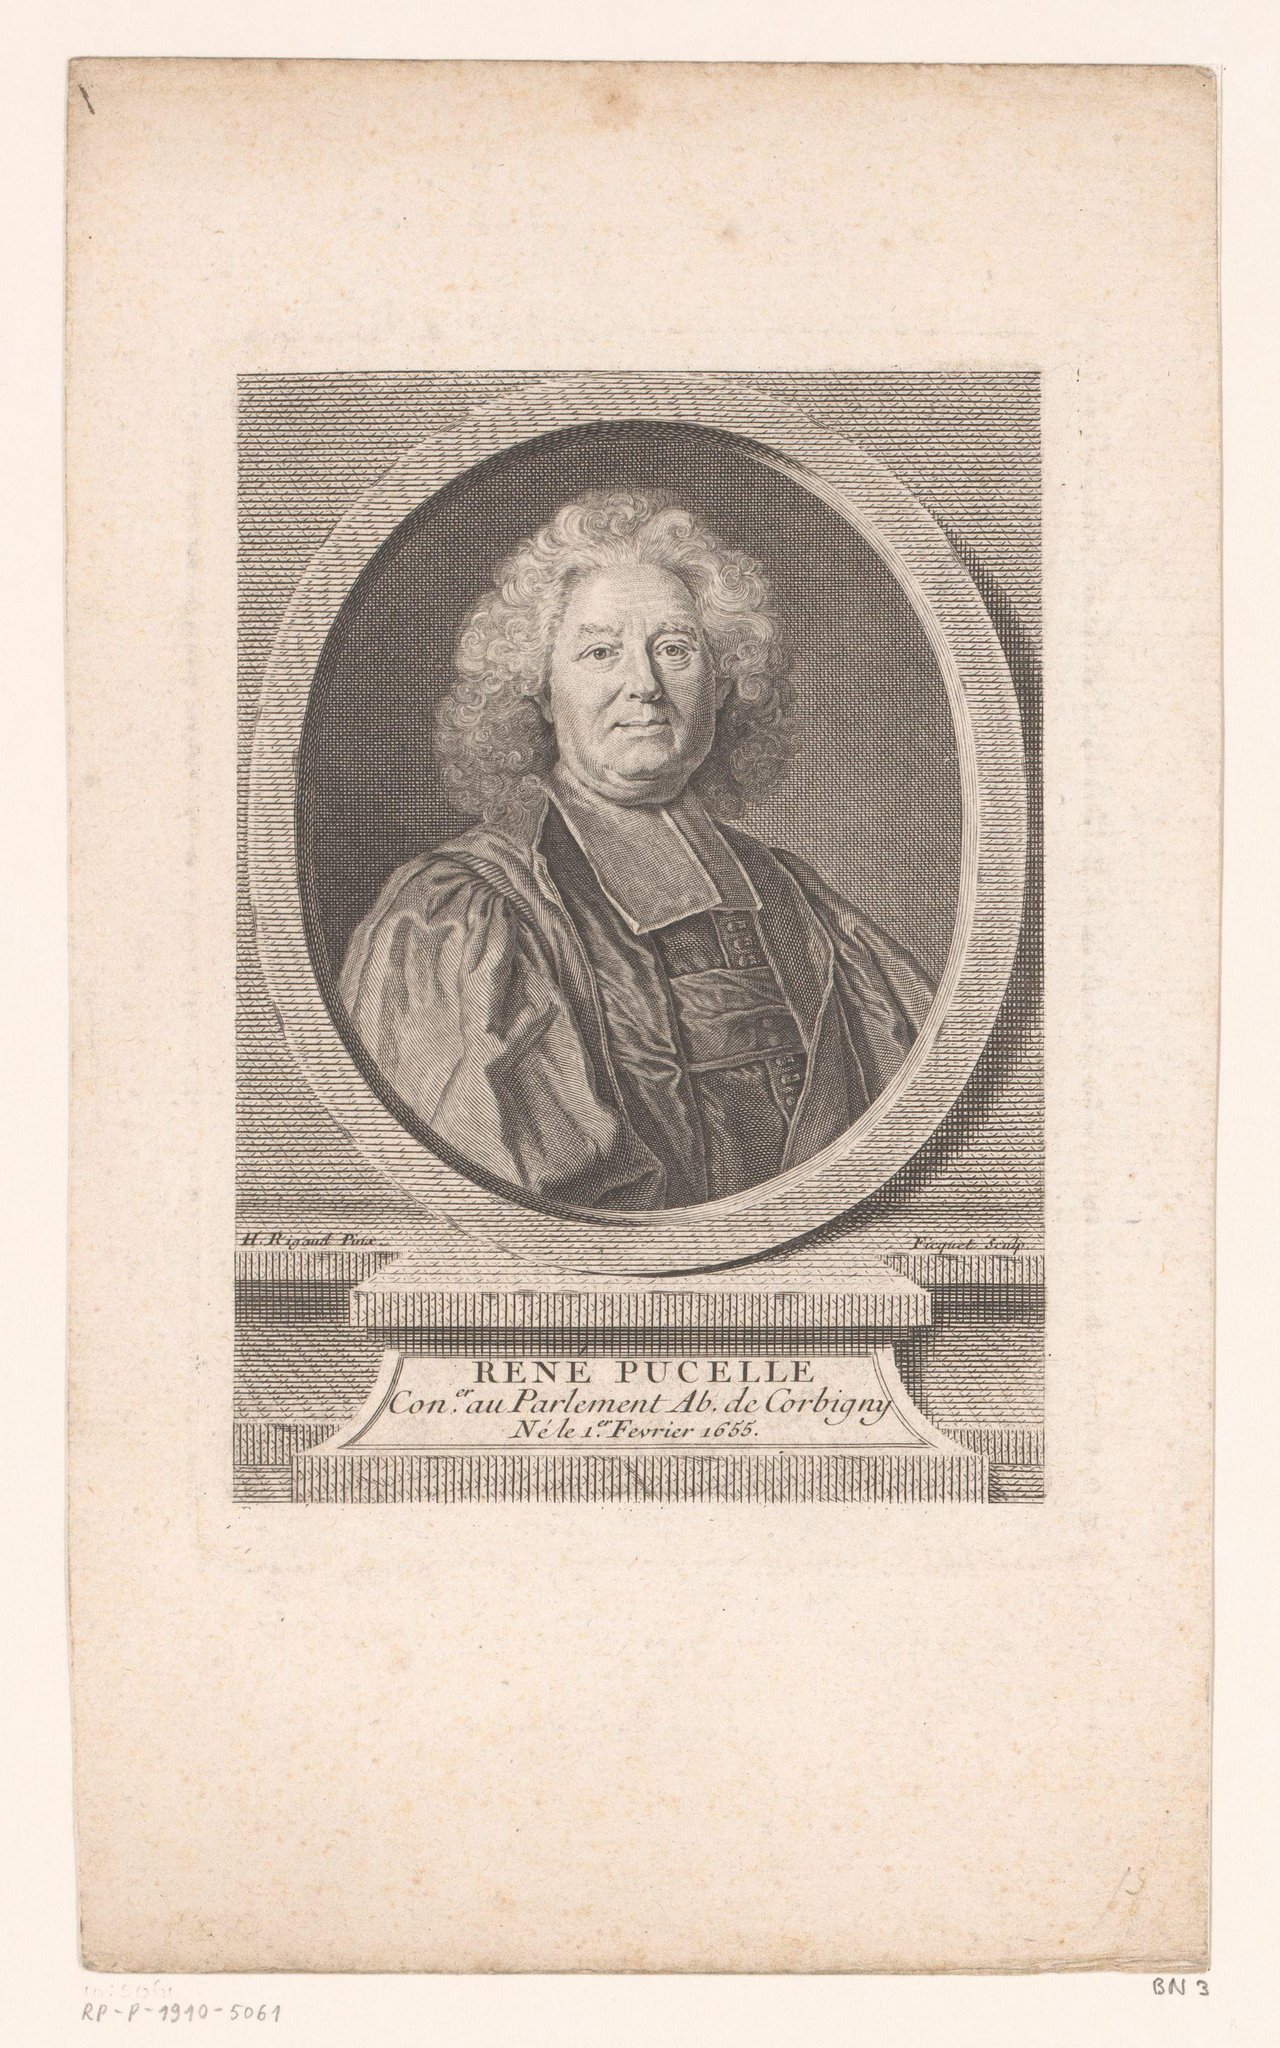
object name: print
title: Portret van René Pucelle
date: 1741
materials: paper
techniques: engraving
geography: france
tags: paris, official; civil servant; functionary (in general), ornament ~ medallion, historical persons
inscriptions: collector's mark: Lugt 2228